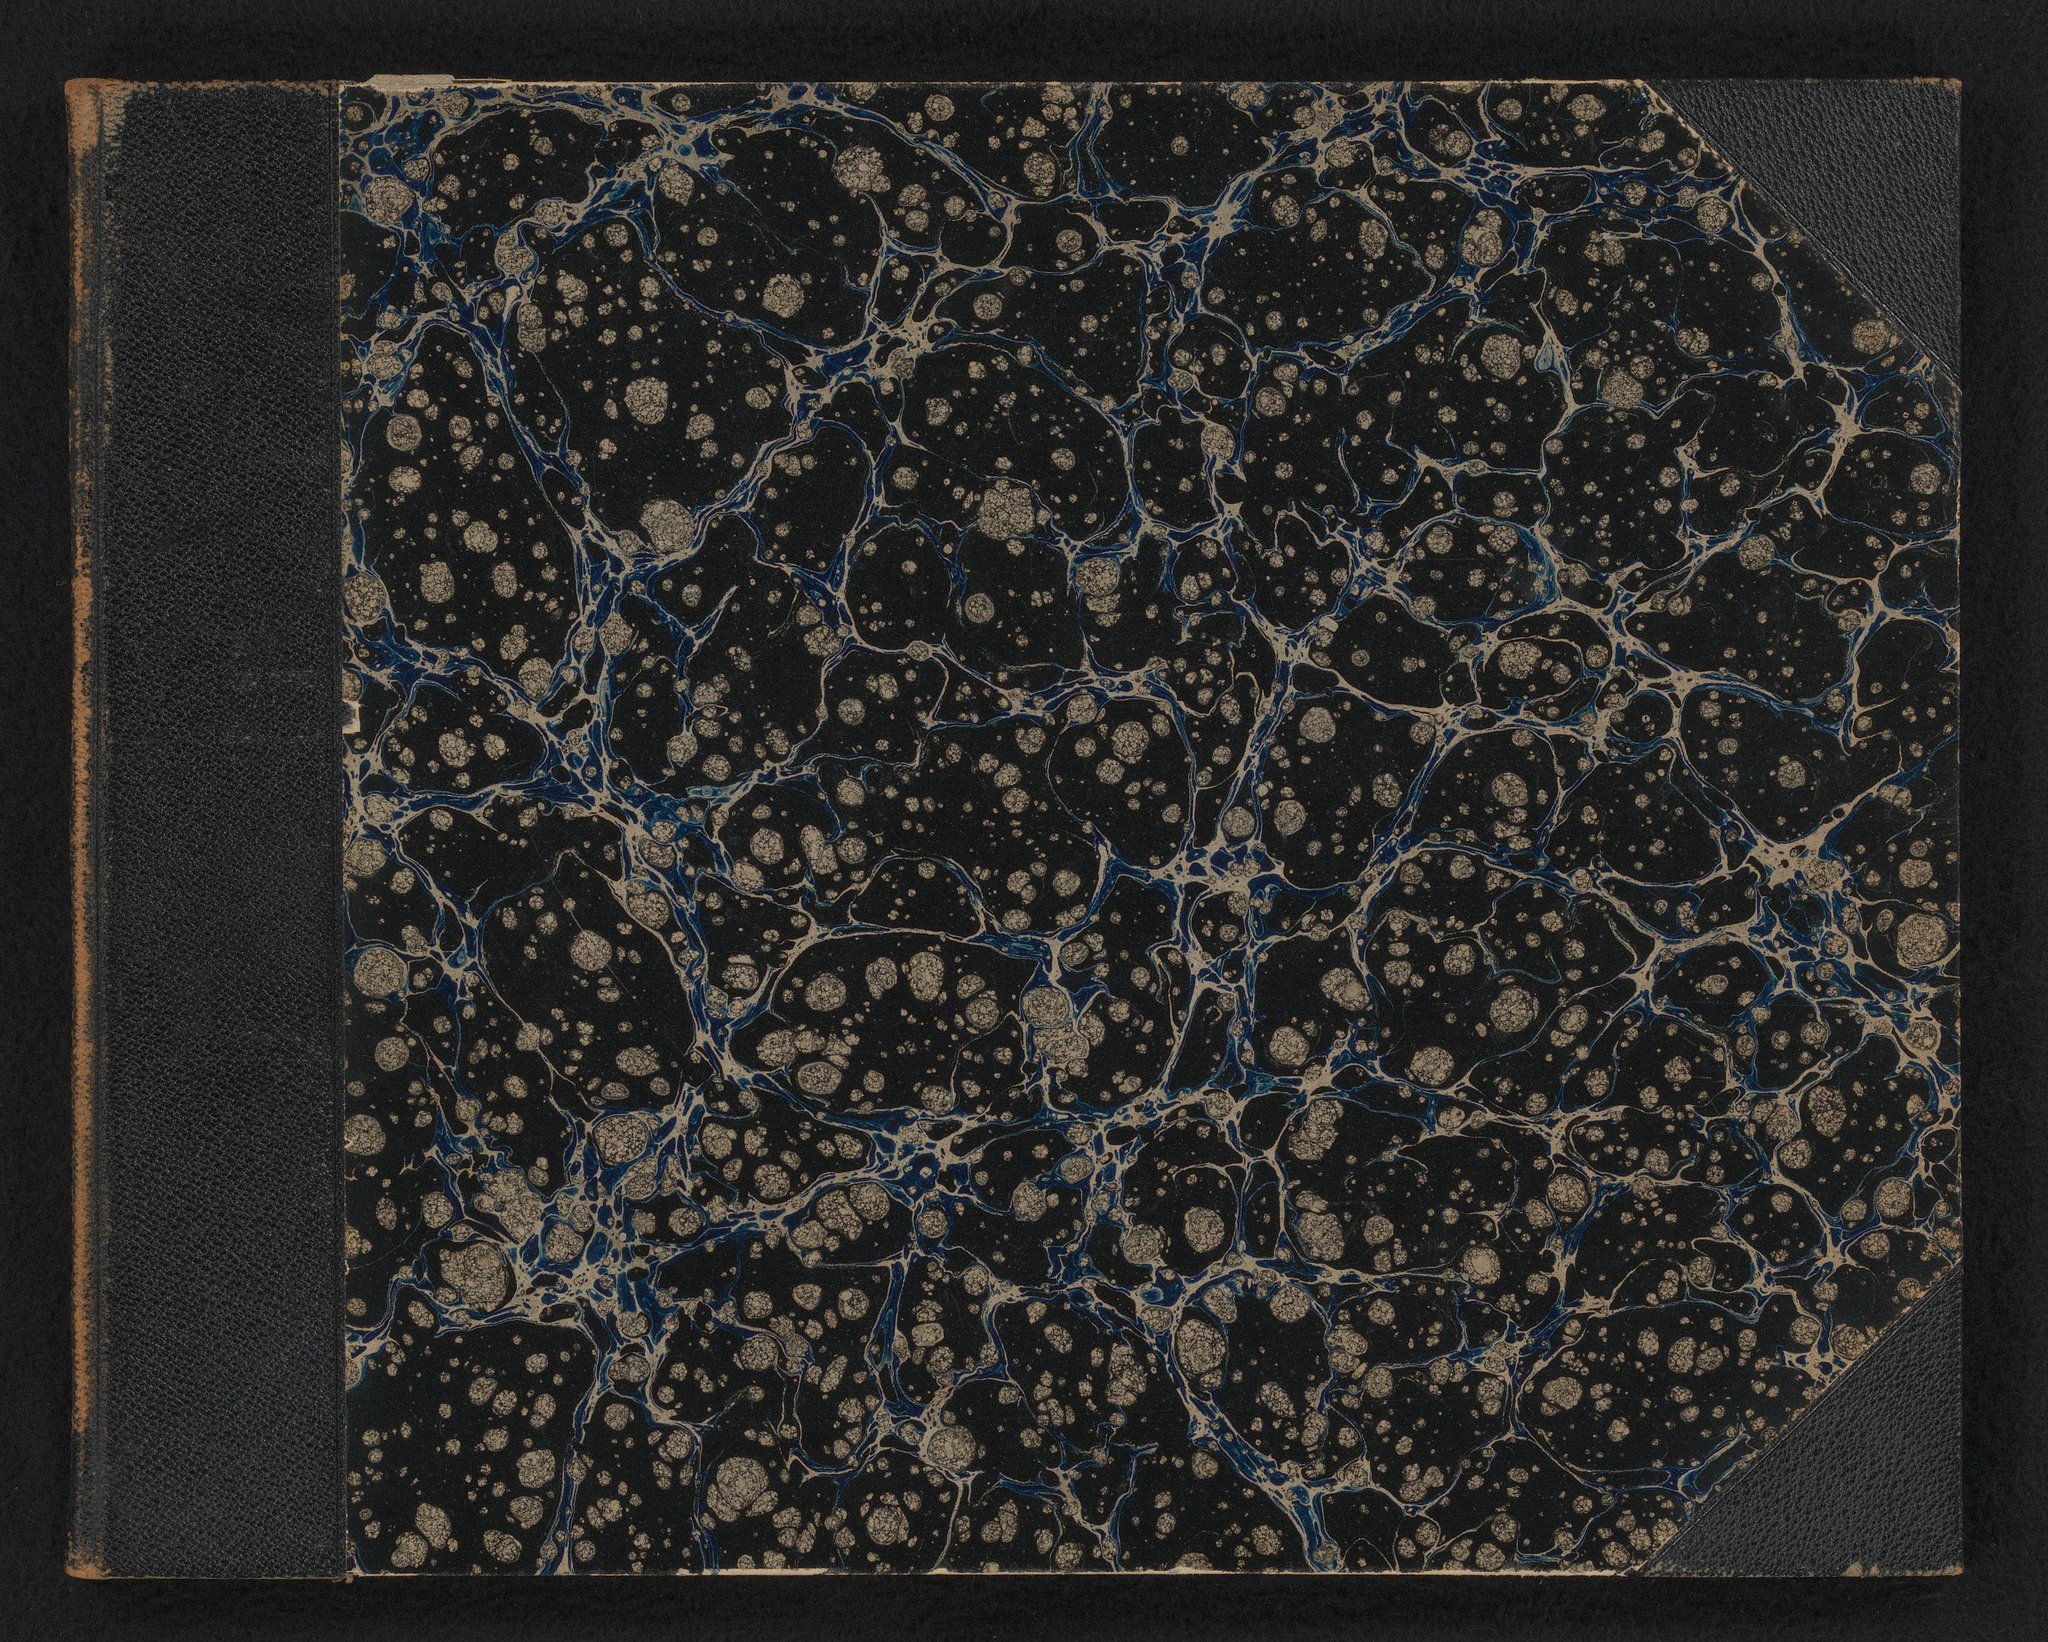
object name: album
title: Album met het eerste deel van het prentwerk: Le Theatre de la Guerre, dans les Pays-Bas, 1696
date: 1696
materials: cardboard, leather, paper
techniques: engraving, etching, letterpress printing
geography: paris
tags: negenjarige oorlog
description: Album met de 25 platen in het eerste deel van het prentwerk: Le Theatre de la Guerre, dans les Pays-Bas, door Nicolas de Fer uitgegeven in 1696. Boekband van zwart leer en zwart gemarmerd papier. Platen met plannen (afkomstig van Sébastien Le Prestre, Seigneur de Vauban) van vermaarde sterke steden en vestingen in de Negenjarige Oorlog in de Nederlanden. Titel in het Frans.